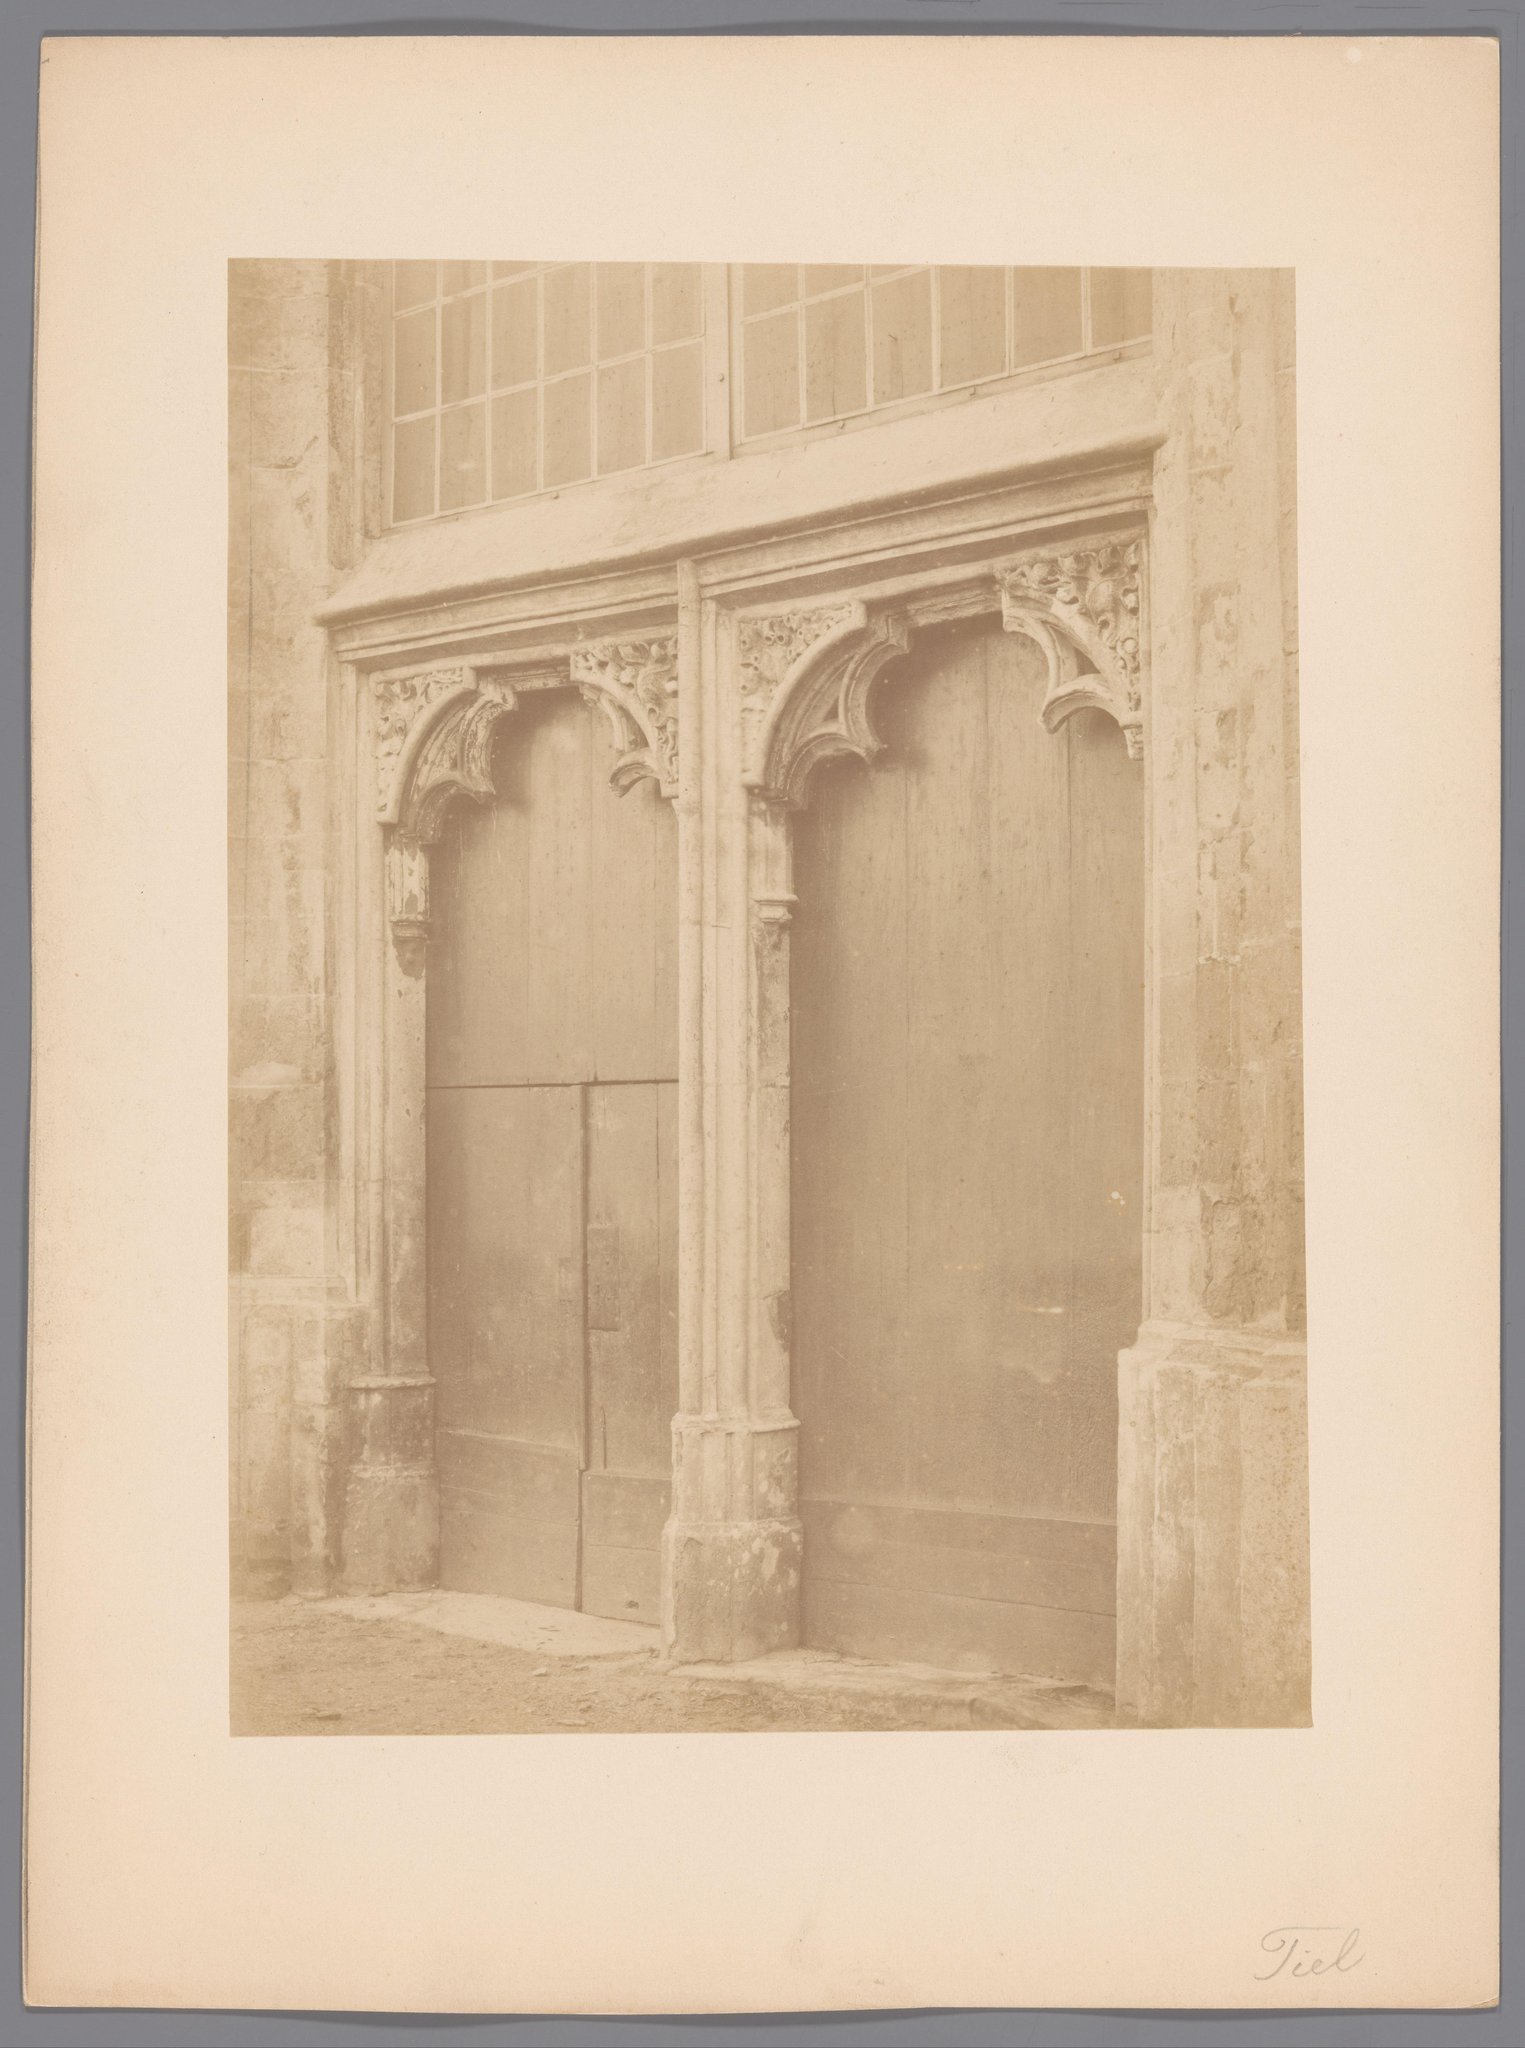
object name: photograph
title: Ingang van de toren van de Grote of Sint-Maartenskerk te Tiel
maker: anoniem (monumentenzorg)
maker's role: fotograaf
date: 1893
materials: cardboard, photographic support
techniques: albumen print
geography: tiel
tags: parts of church exterior and annexes: tower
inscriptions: annotation: ‘Tiel’, annotation: ‘Tiel/ Toegang tot den toren v/d groote of st. Maartenskerk/ Maart 1893’